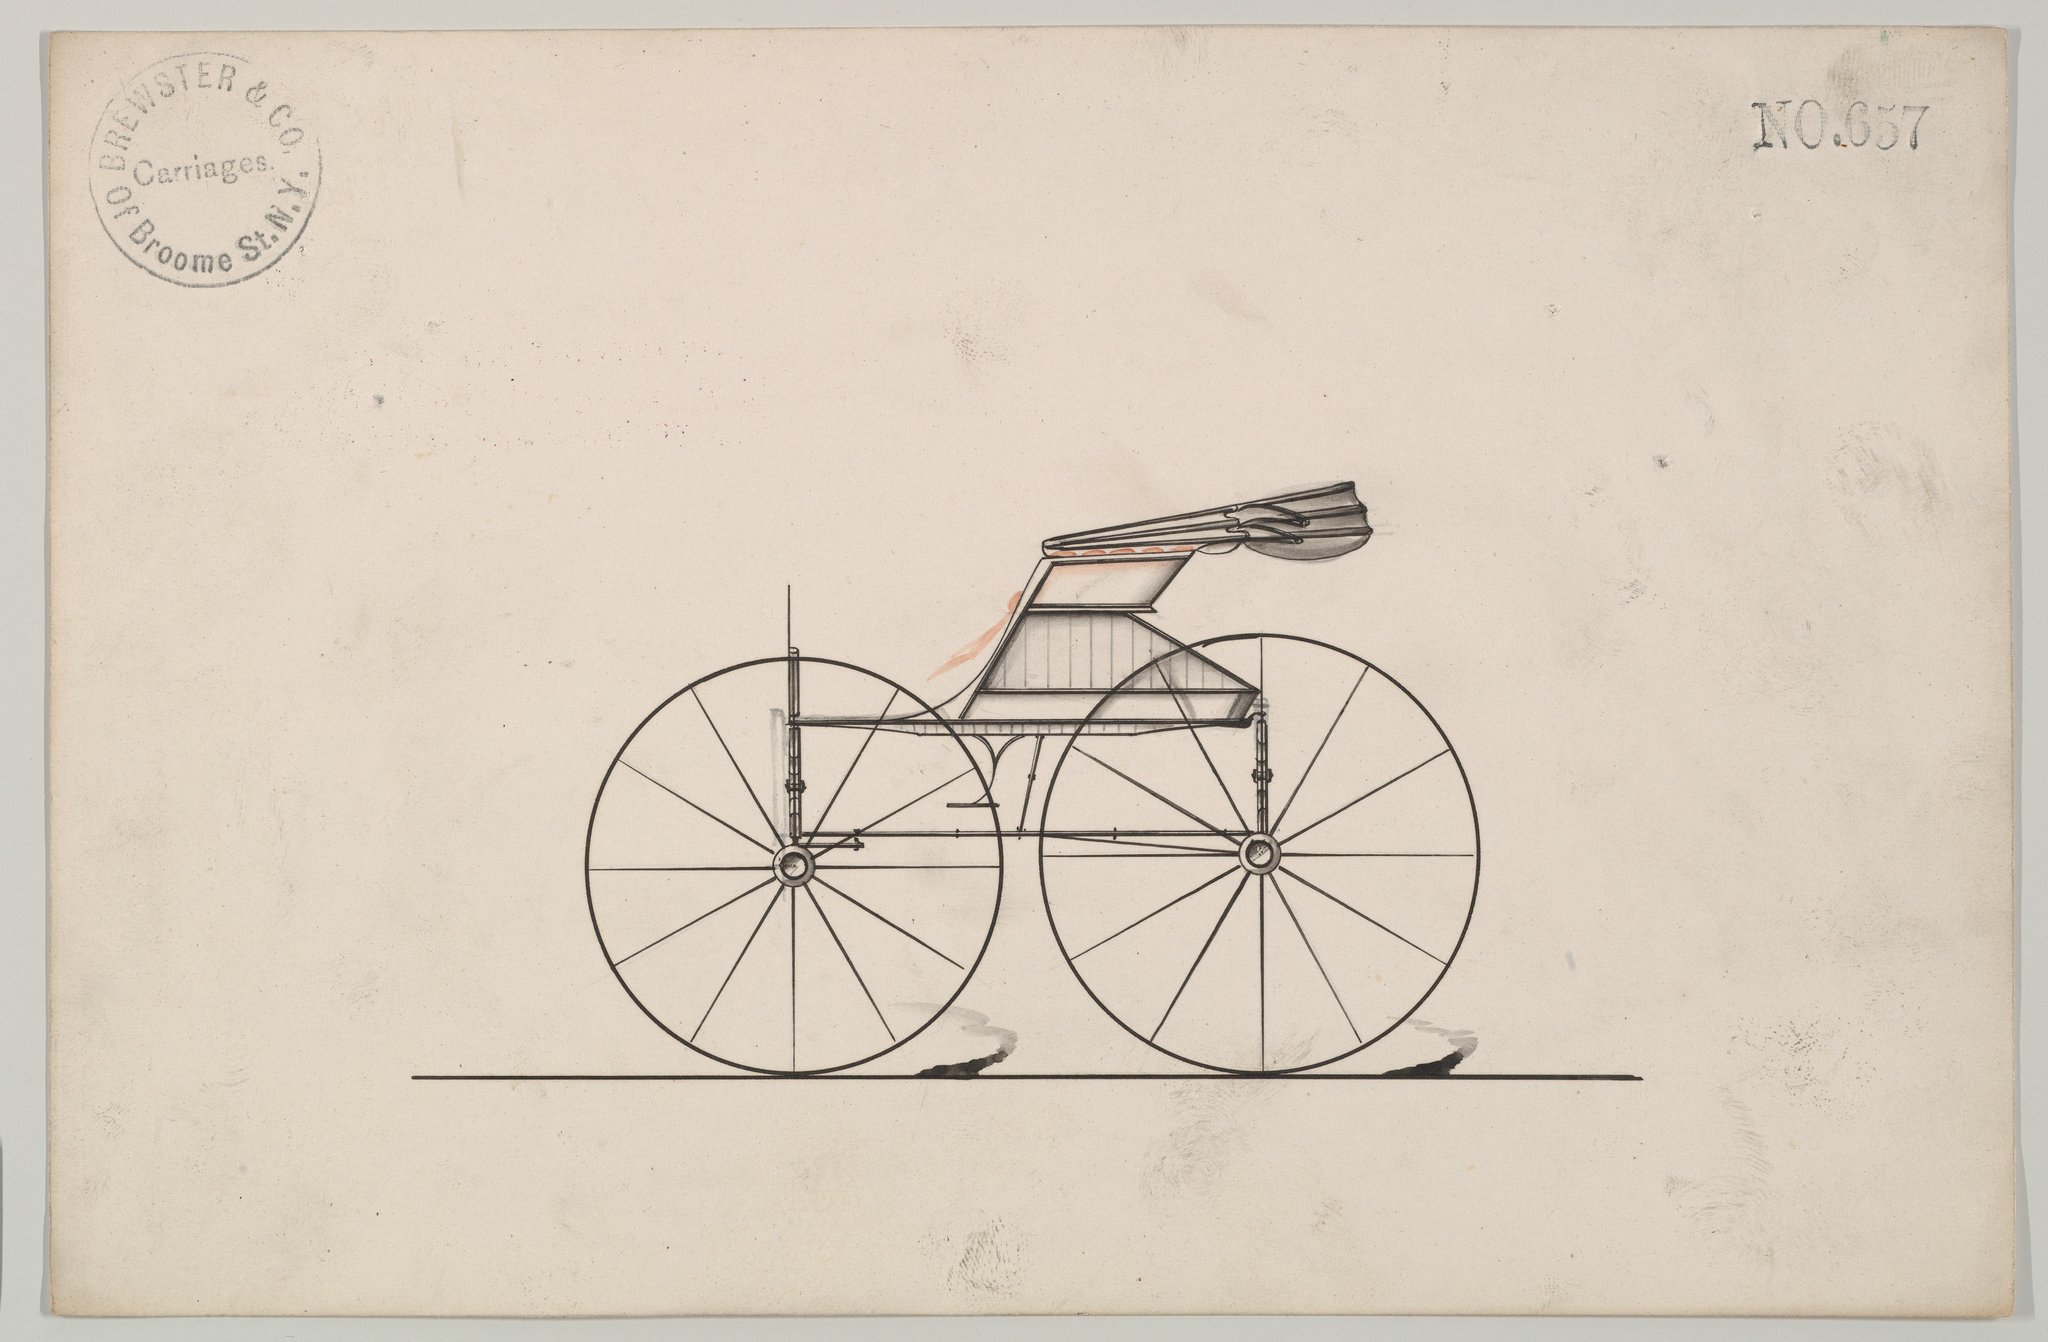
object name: drawing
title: Top Wagon # 657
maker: brewster & co.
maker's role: manufacturer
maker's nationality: american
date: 1865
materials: graphite, ink, watercolor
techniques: pen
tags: carriages